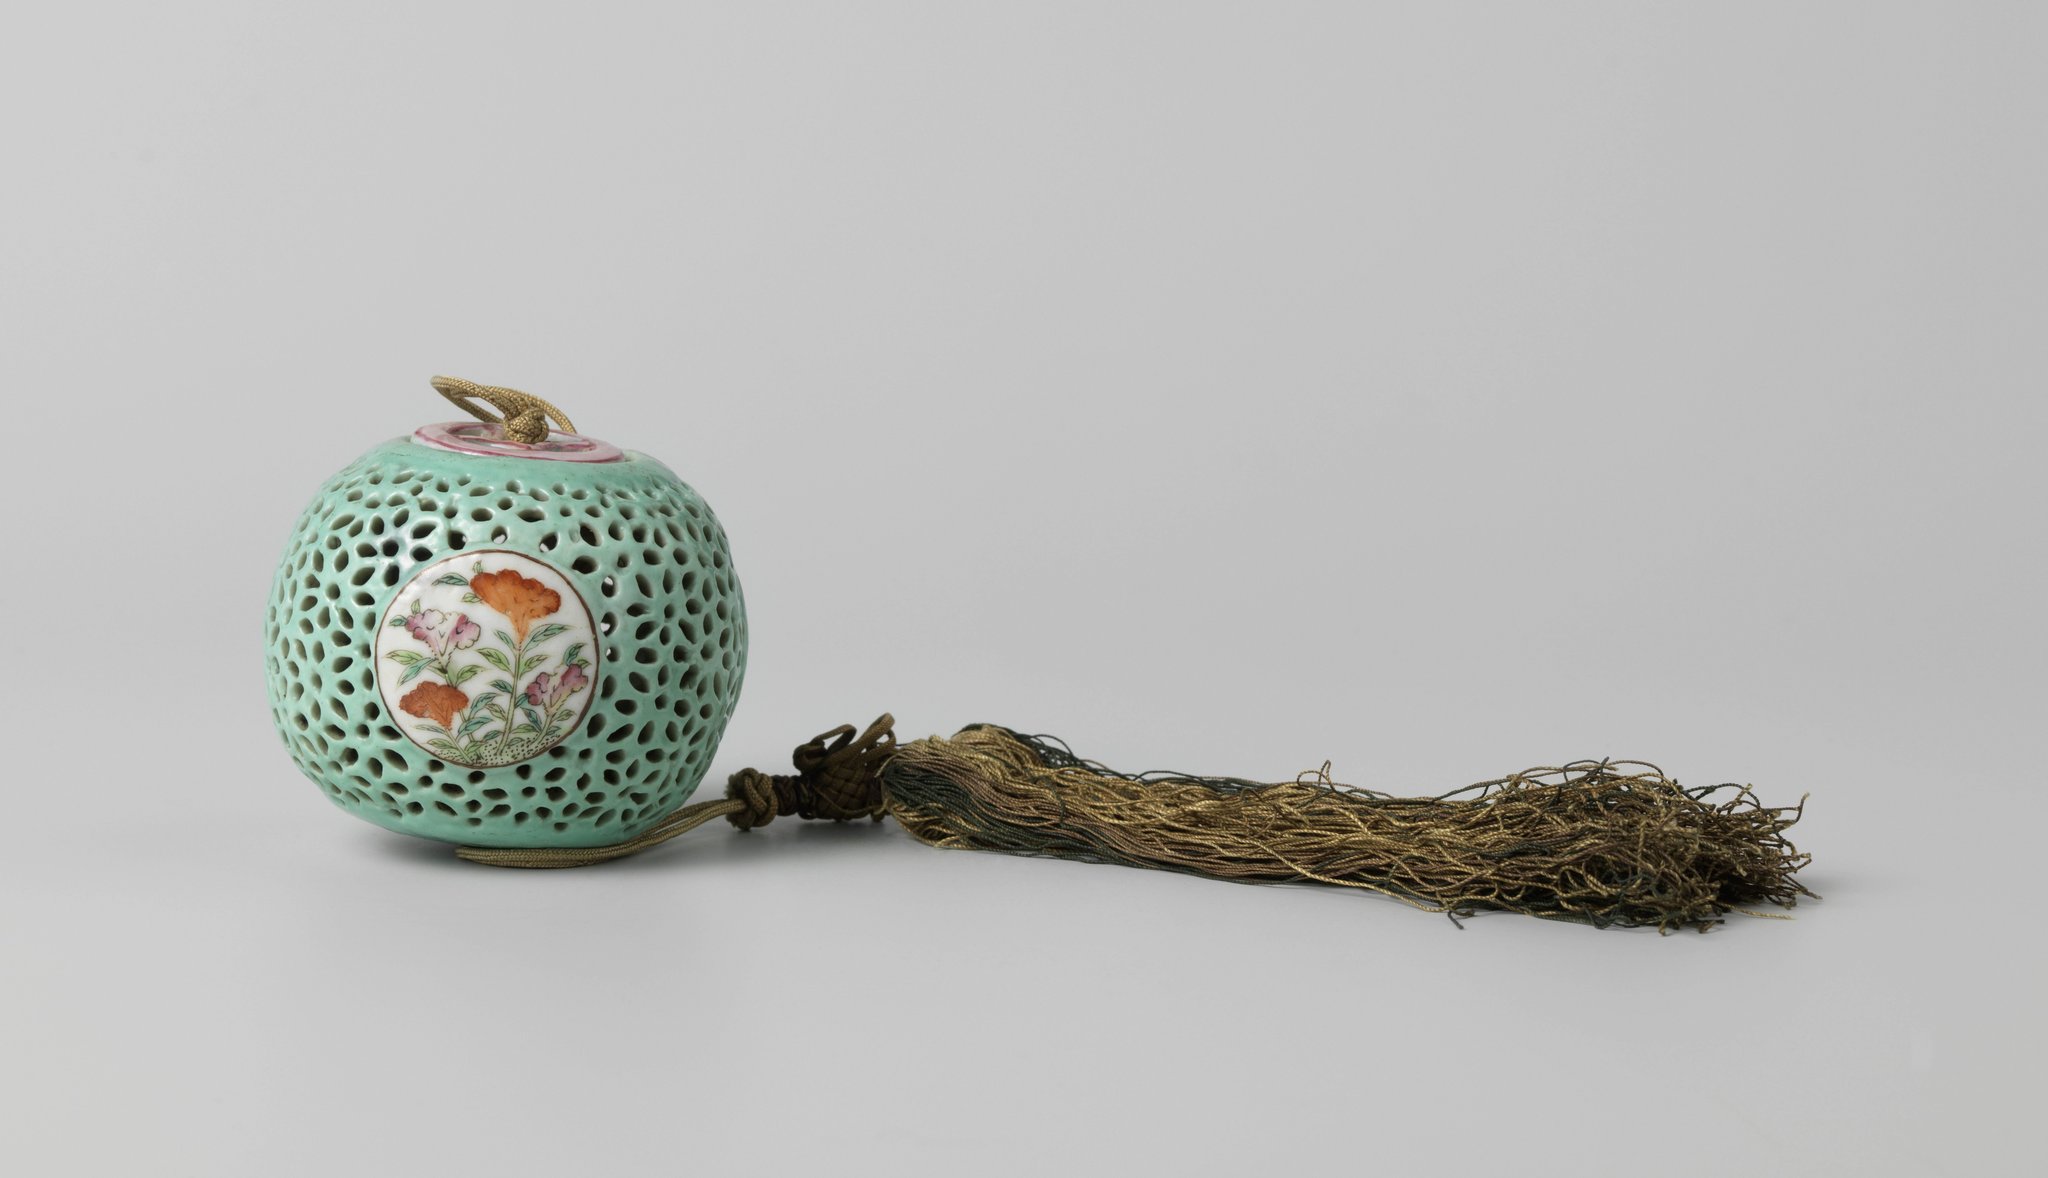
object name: pomander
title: Pierced fragrance ball with silk tassel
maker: Anonymous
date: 1825-1874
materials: glaze, paint, porcelain, silk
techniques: embroidery, firing, turning, vitrification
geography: china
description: Opengewerkte reukbal van porselein met zijden kwast, beschilderd op het glazuur in turquoise, blauw, rood, roze, groen, geel, aubergine en zwart. De wand van de bol met ajourwerk met drie medaillons met bloemtakken. De kwast is met een koord bevestigd aan een los deksel. Email sur biscuit met famille rose kleuren.